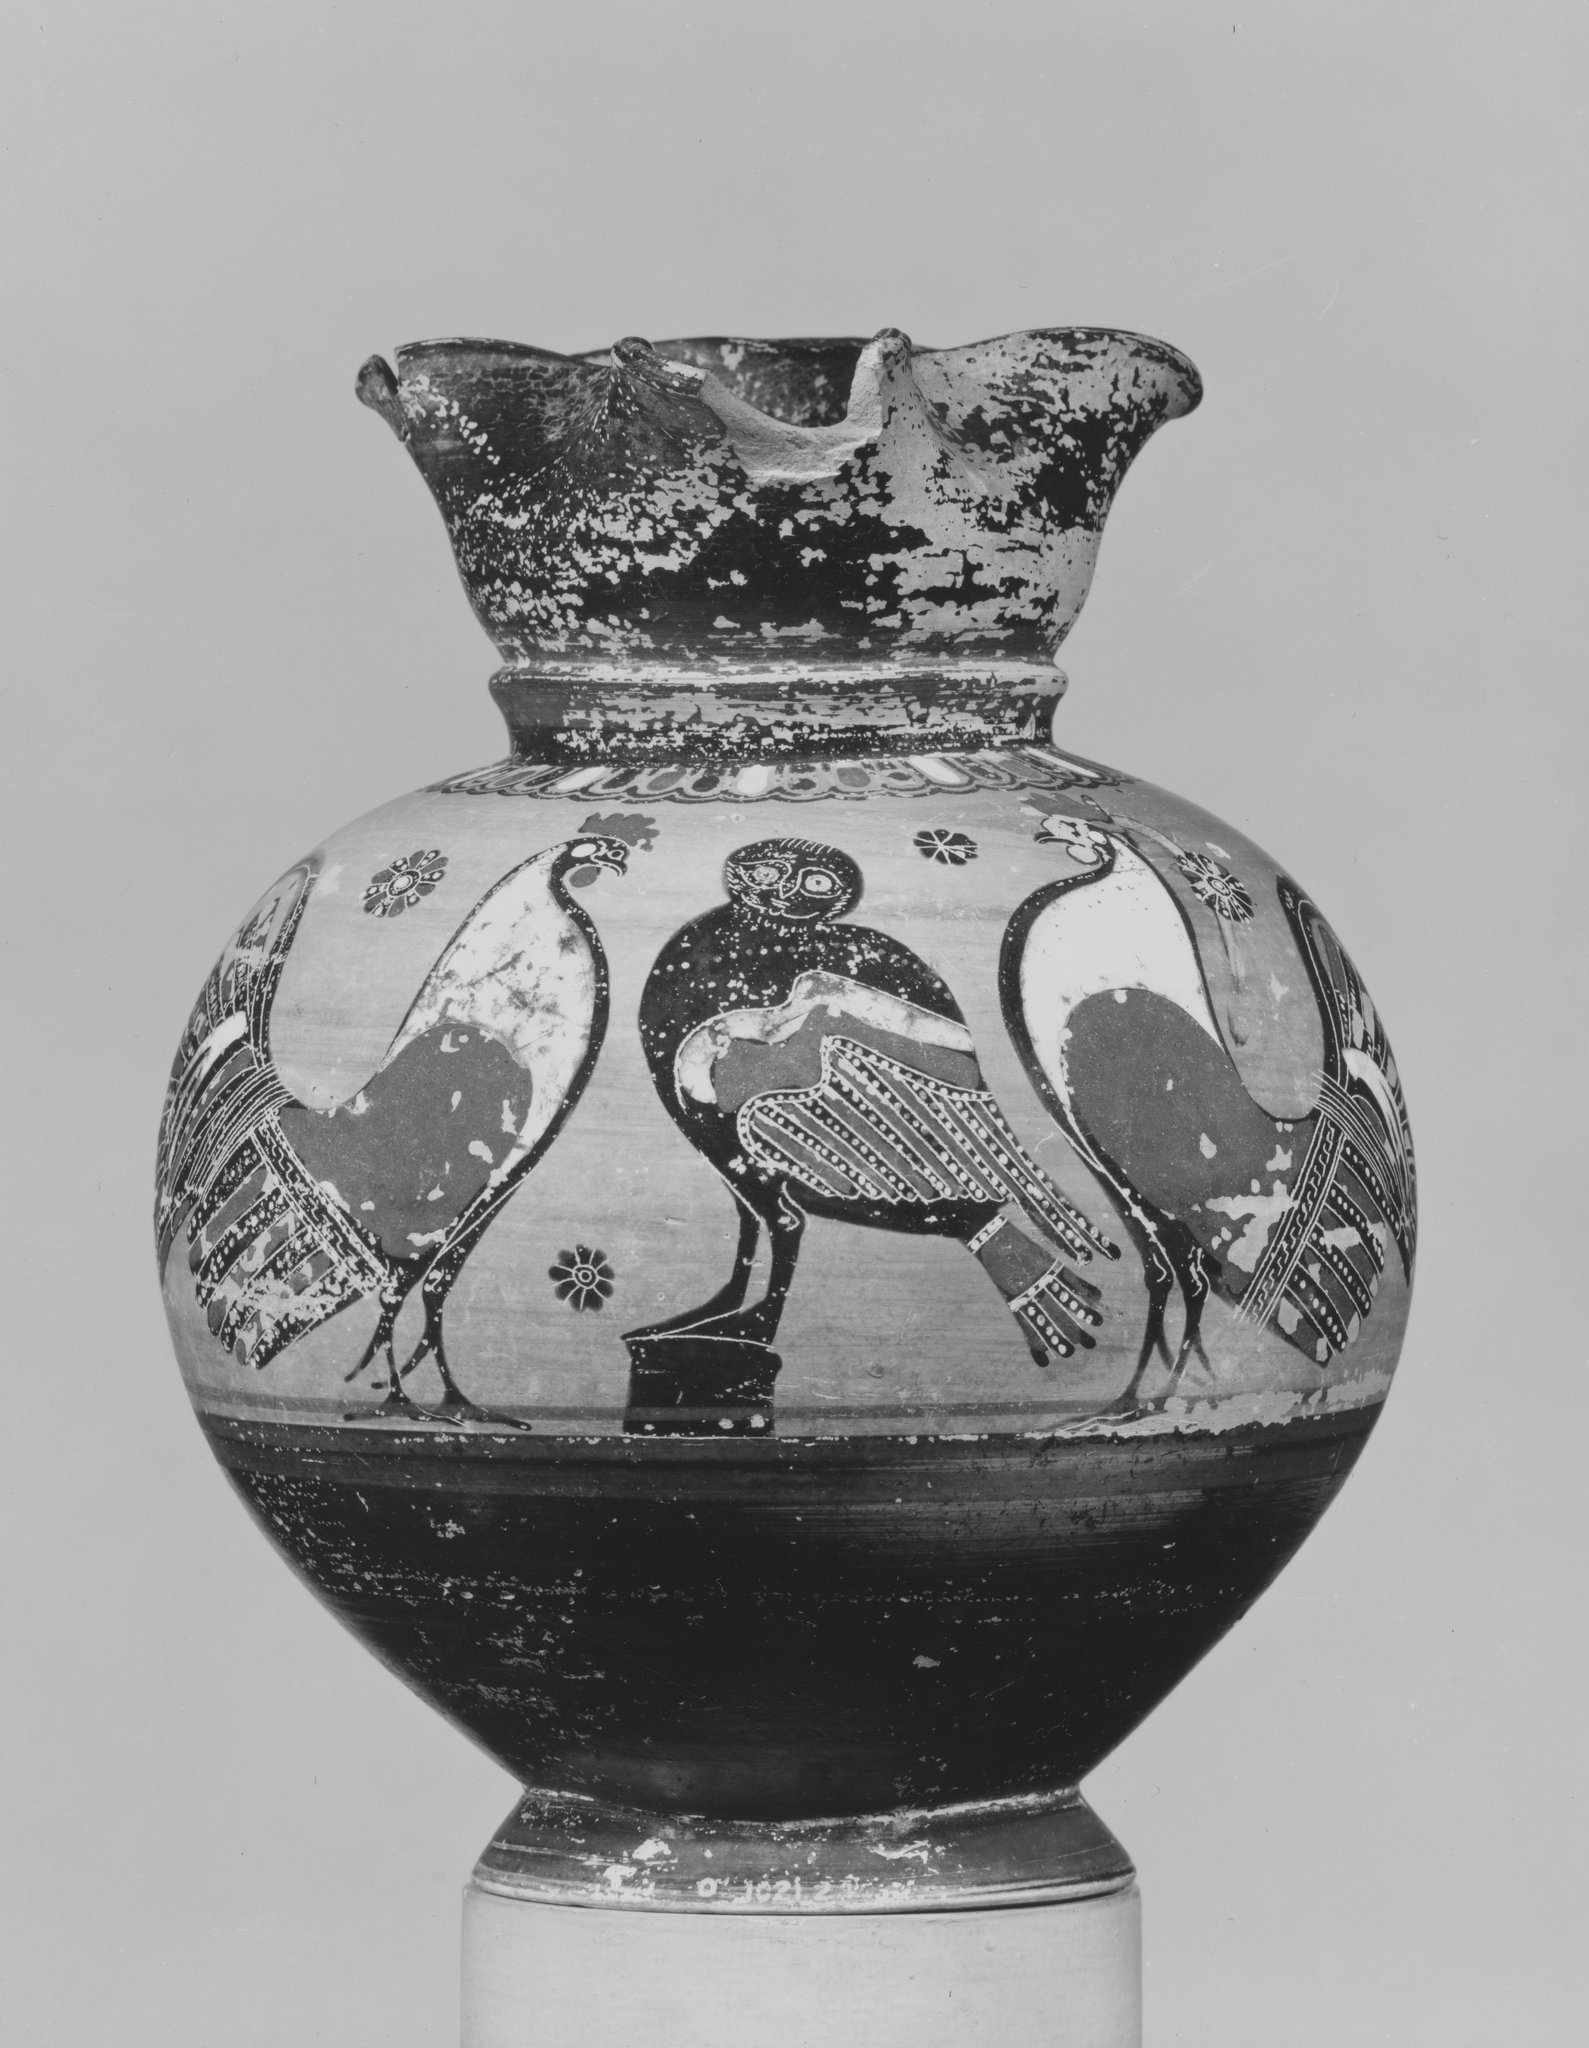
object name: oinochoe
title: Terracotta oinochoe (wine jug)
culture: greek, corinthian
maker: lotus-cross painter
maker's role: artist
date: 570-550 BCE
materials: terracotta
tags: owls,roosters